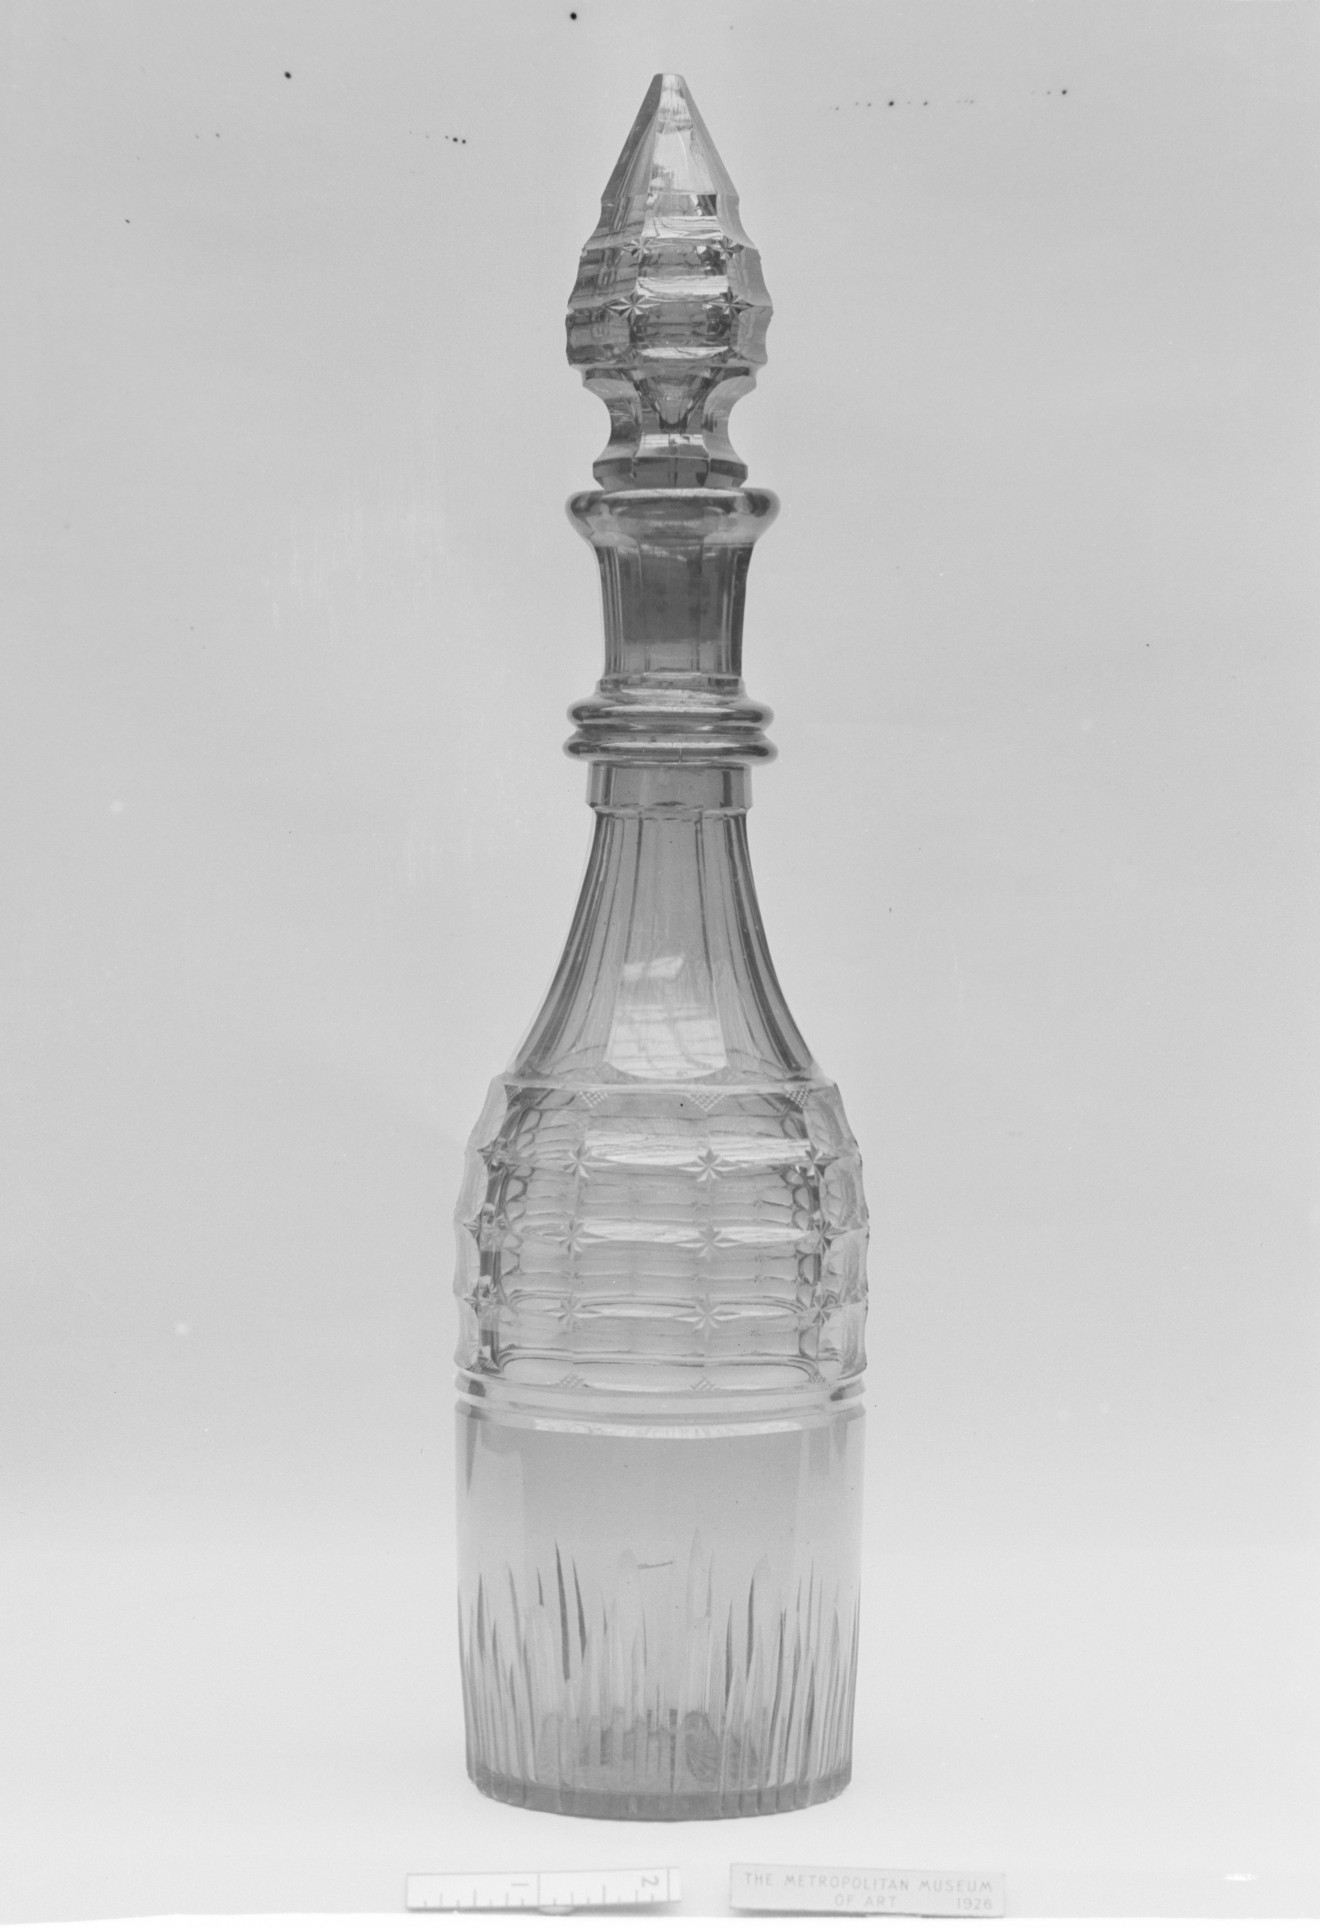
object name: decanter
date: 1834-1866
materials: glass